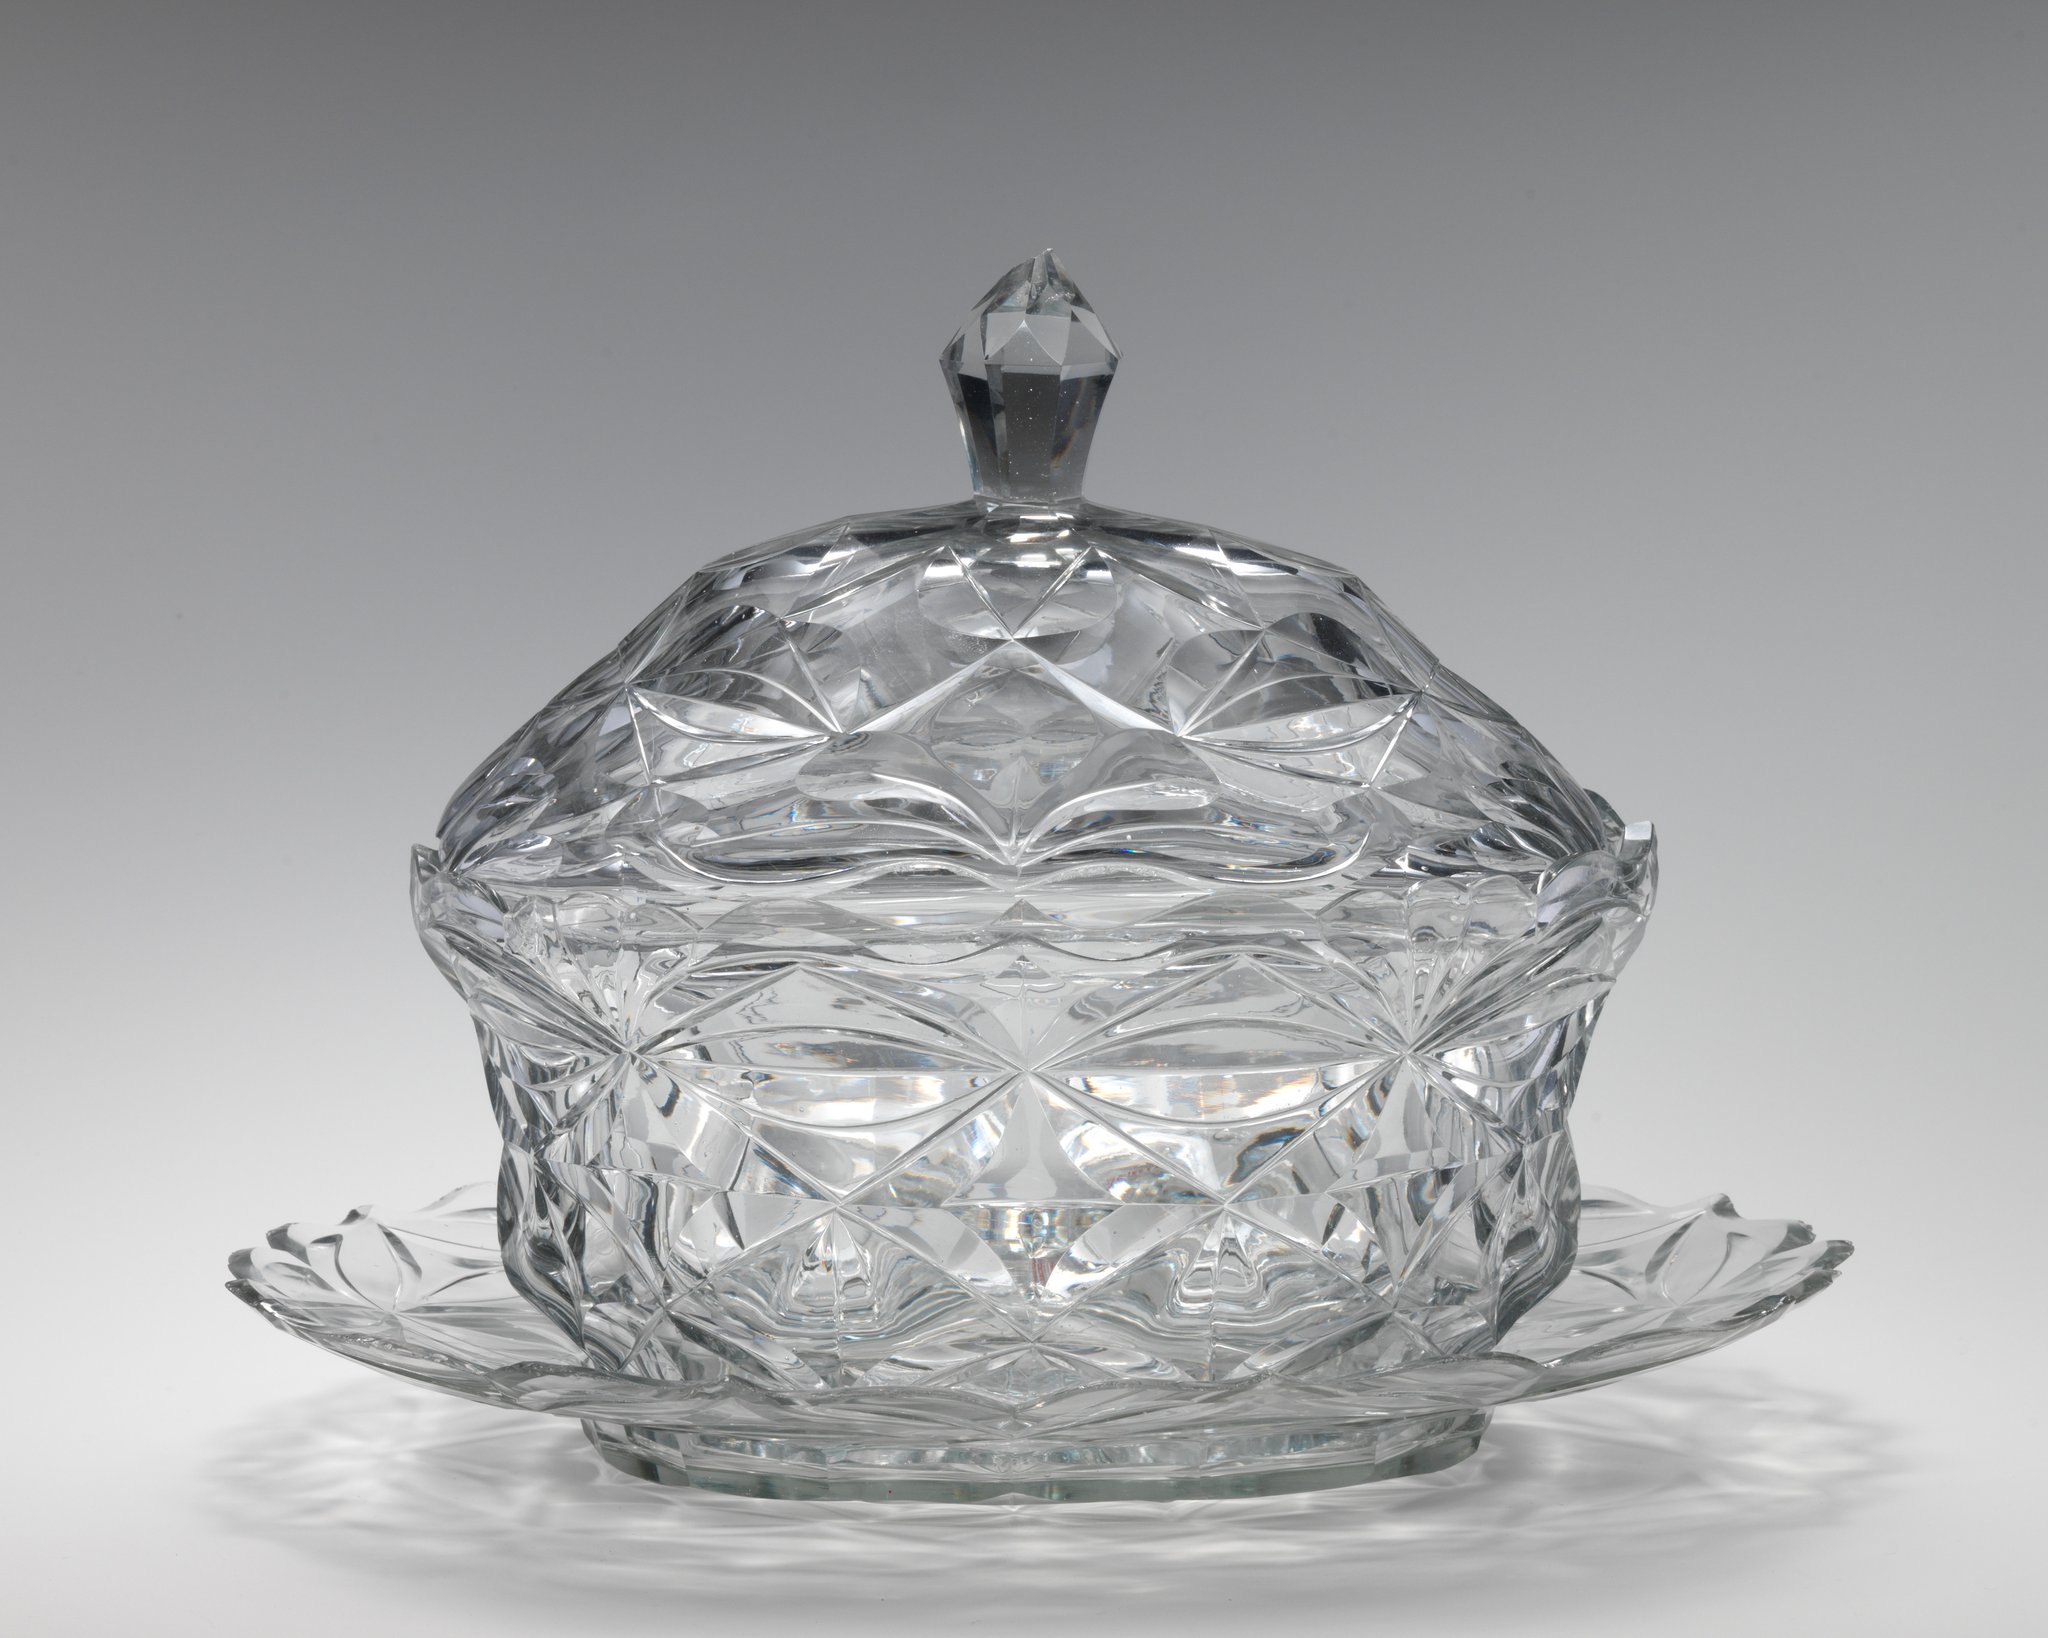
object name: dish with cover and stand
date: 1801-1900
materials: glass